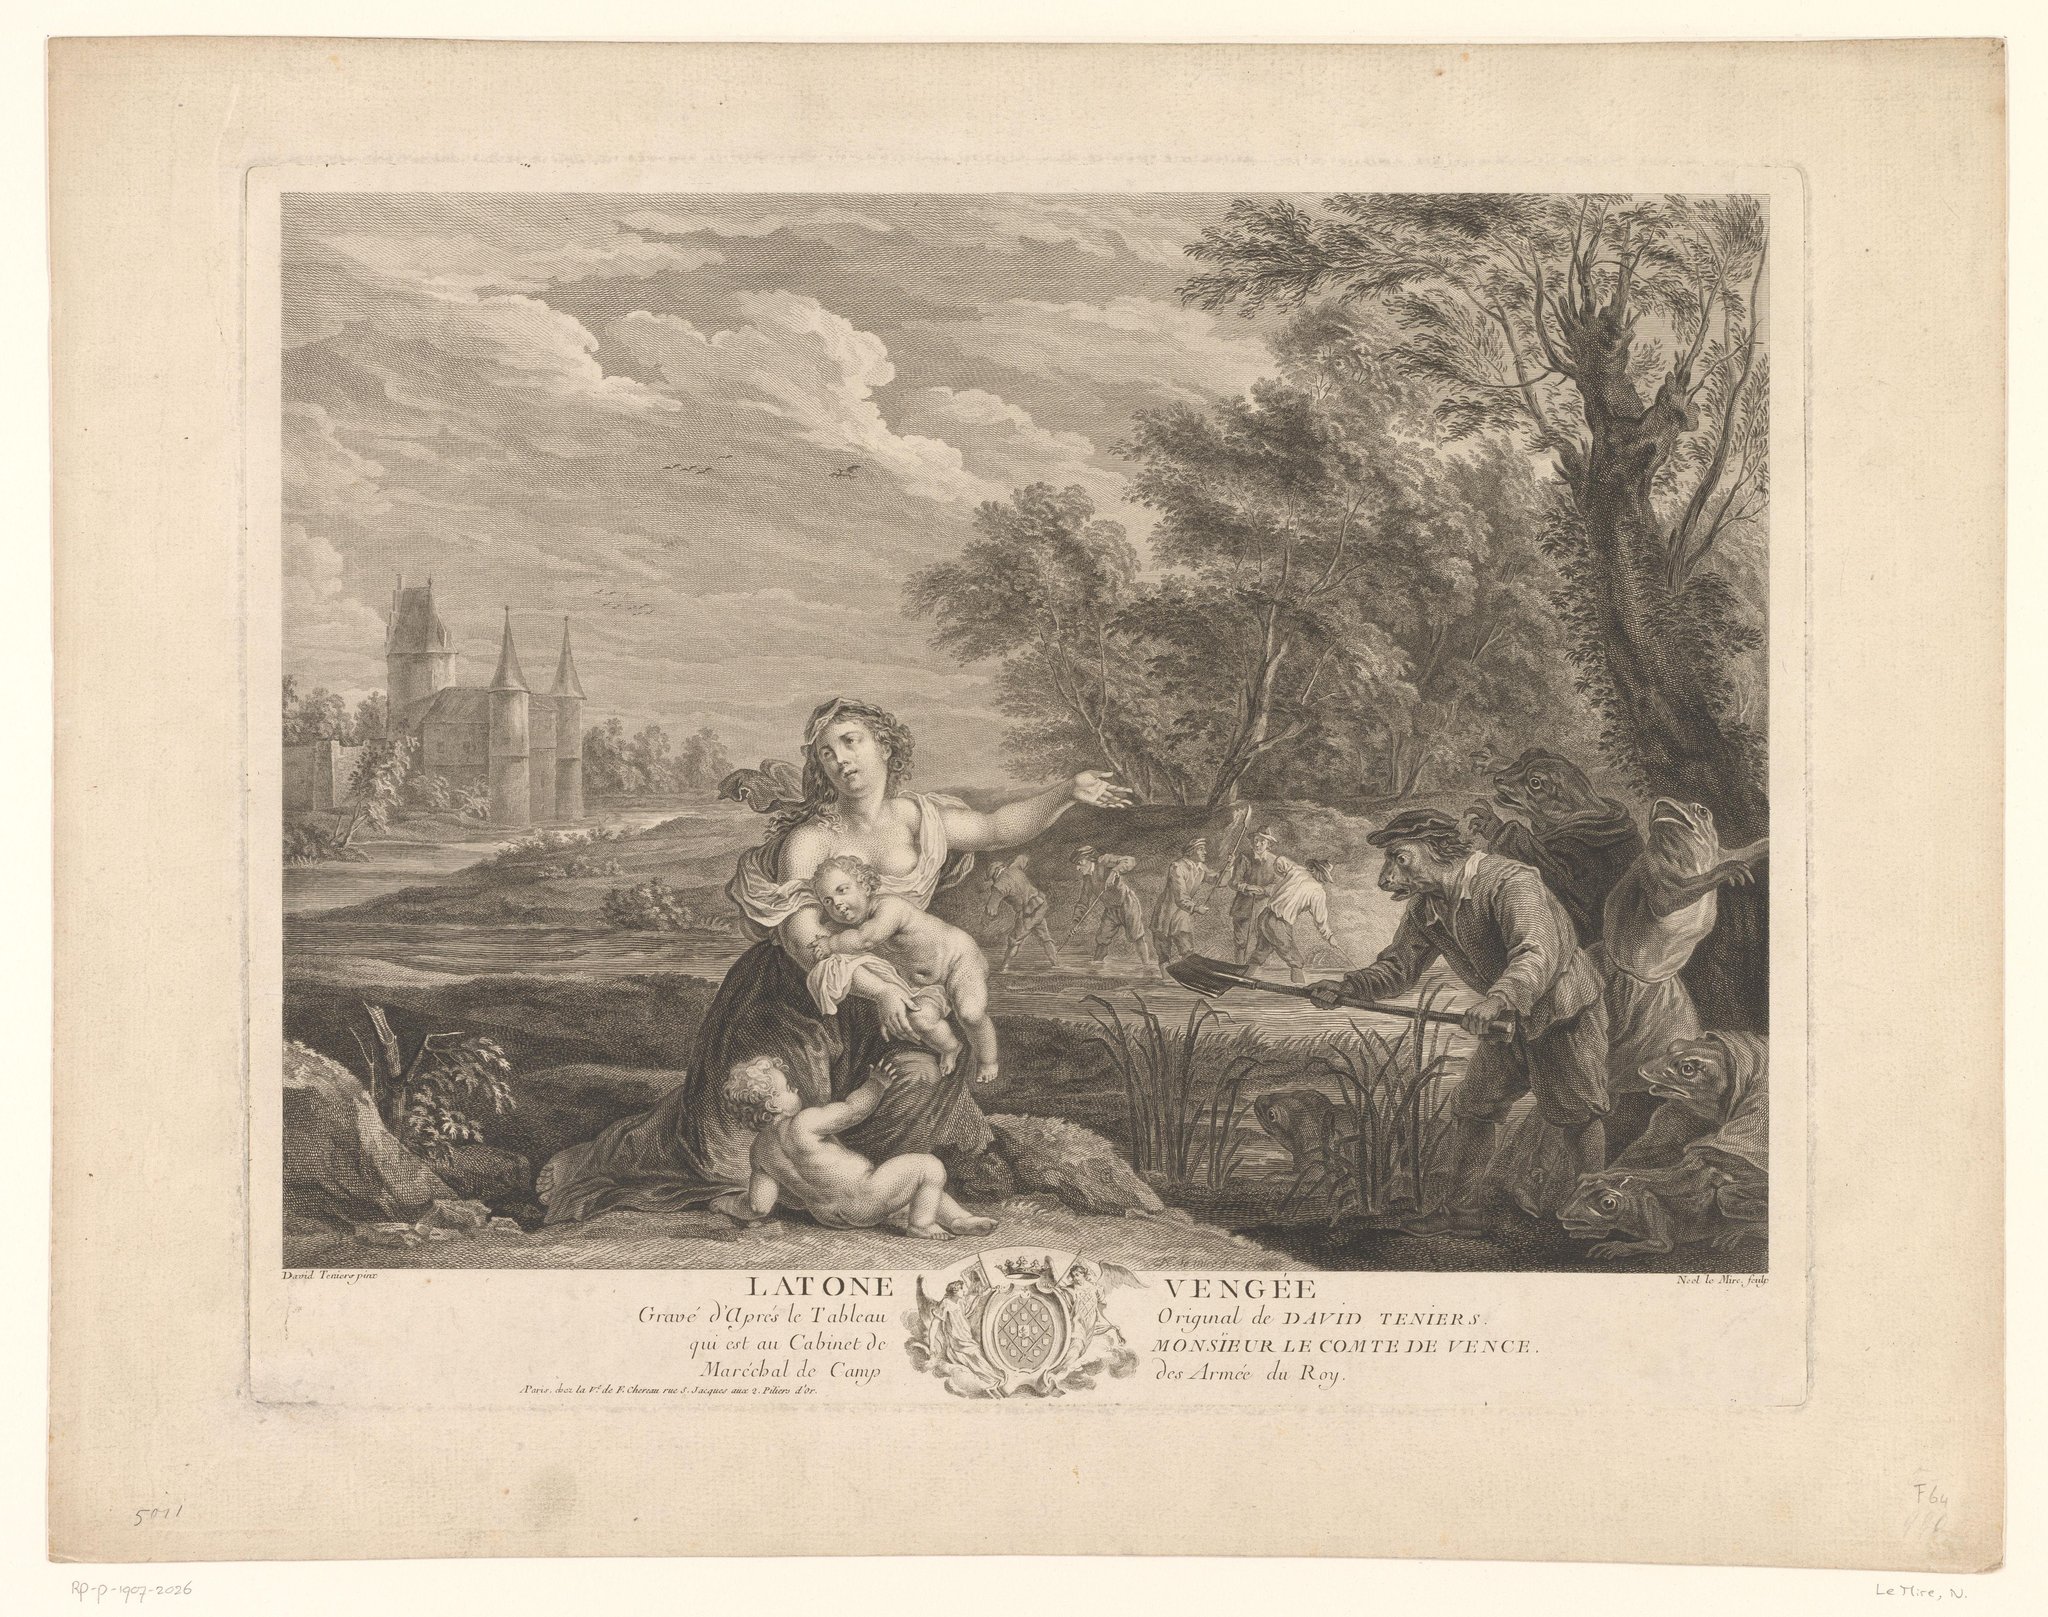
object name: print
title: Latone vengée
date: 1754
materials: paper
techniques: engraving, etching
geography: paris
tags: lycian farmers changed into frogs: latona changes lycian farmers into frogs, because while they were weeding a marsh, they prevented her and her children from quenching their thirst (ovid, metamorphoses vi 369), armorial bearing, heraldry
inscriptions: watermark, collector's mark: Lugt 2228